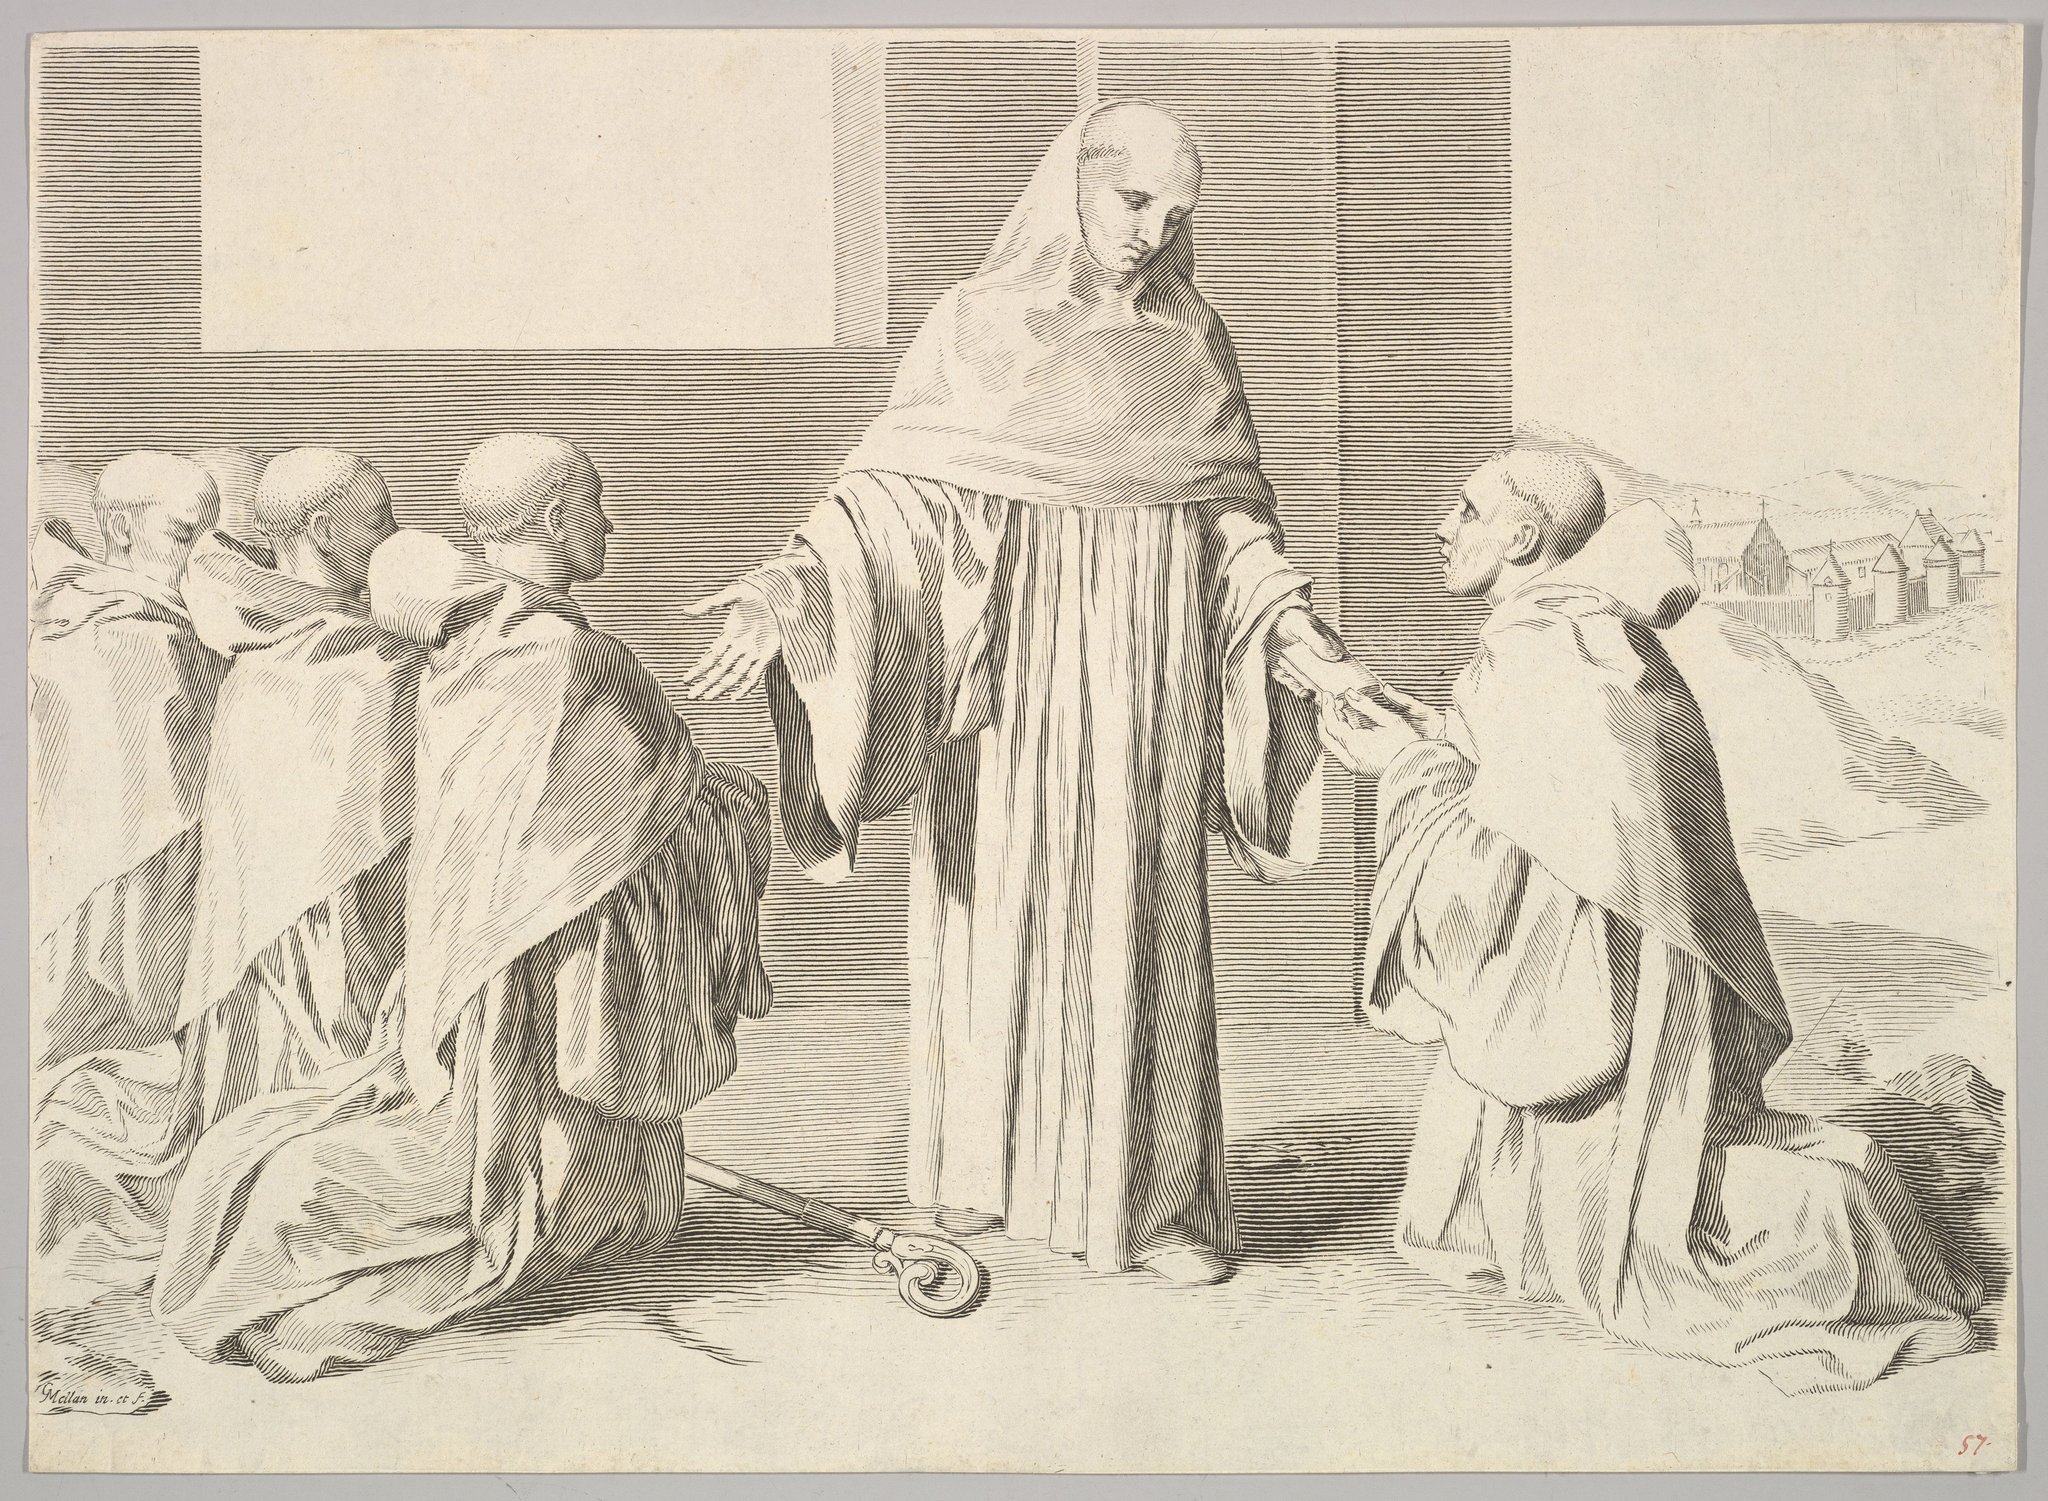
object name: print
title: St. Bernard Presenting the Rule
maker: claude mellan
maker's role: artist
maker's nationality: french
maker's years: 1598-1688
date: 1600-1688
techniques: engraving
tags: monks,saints